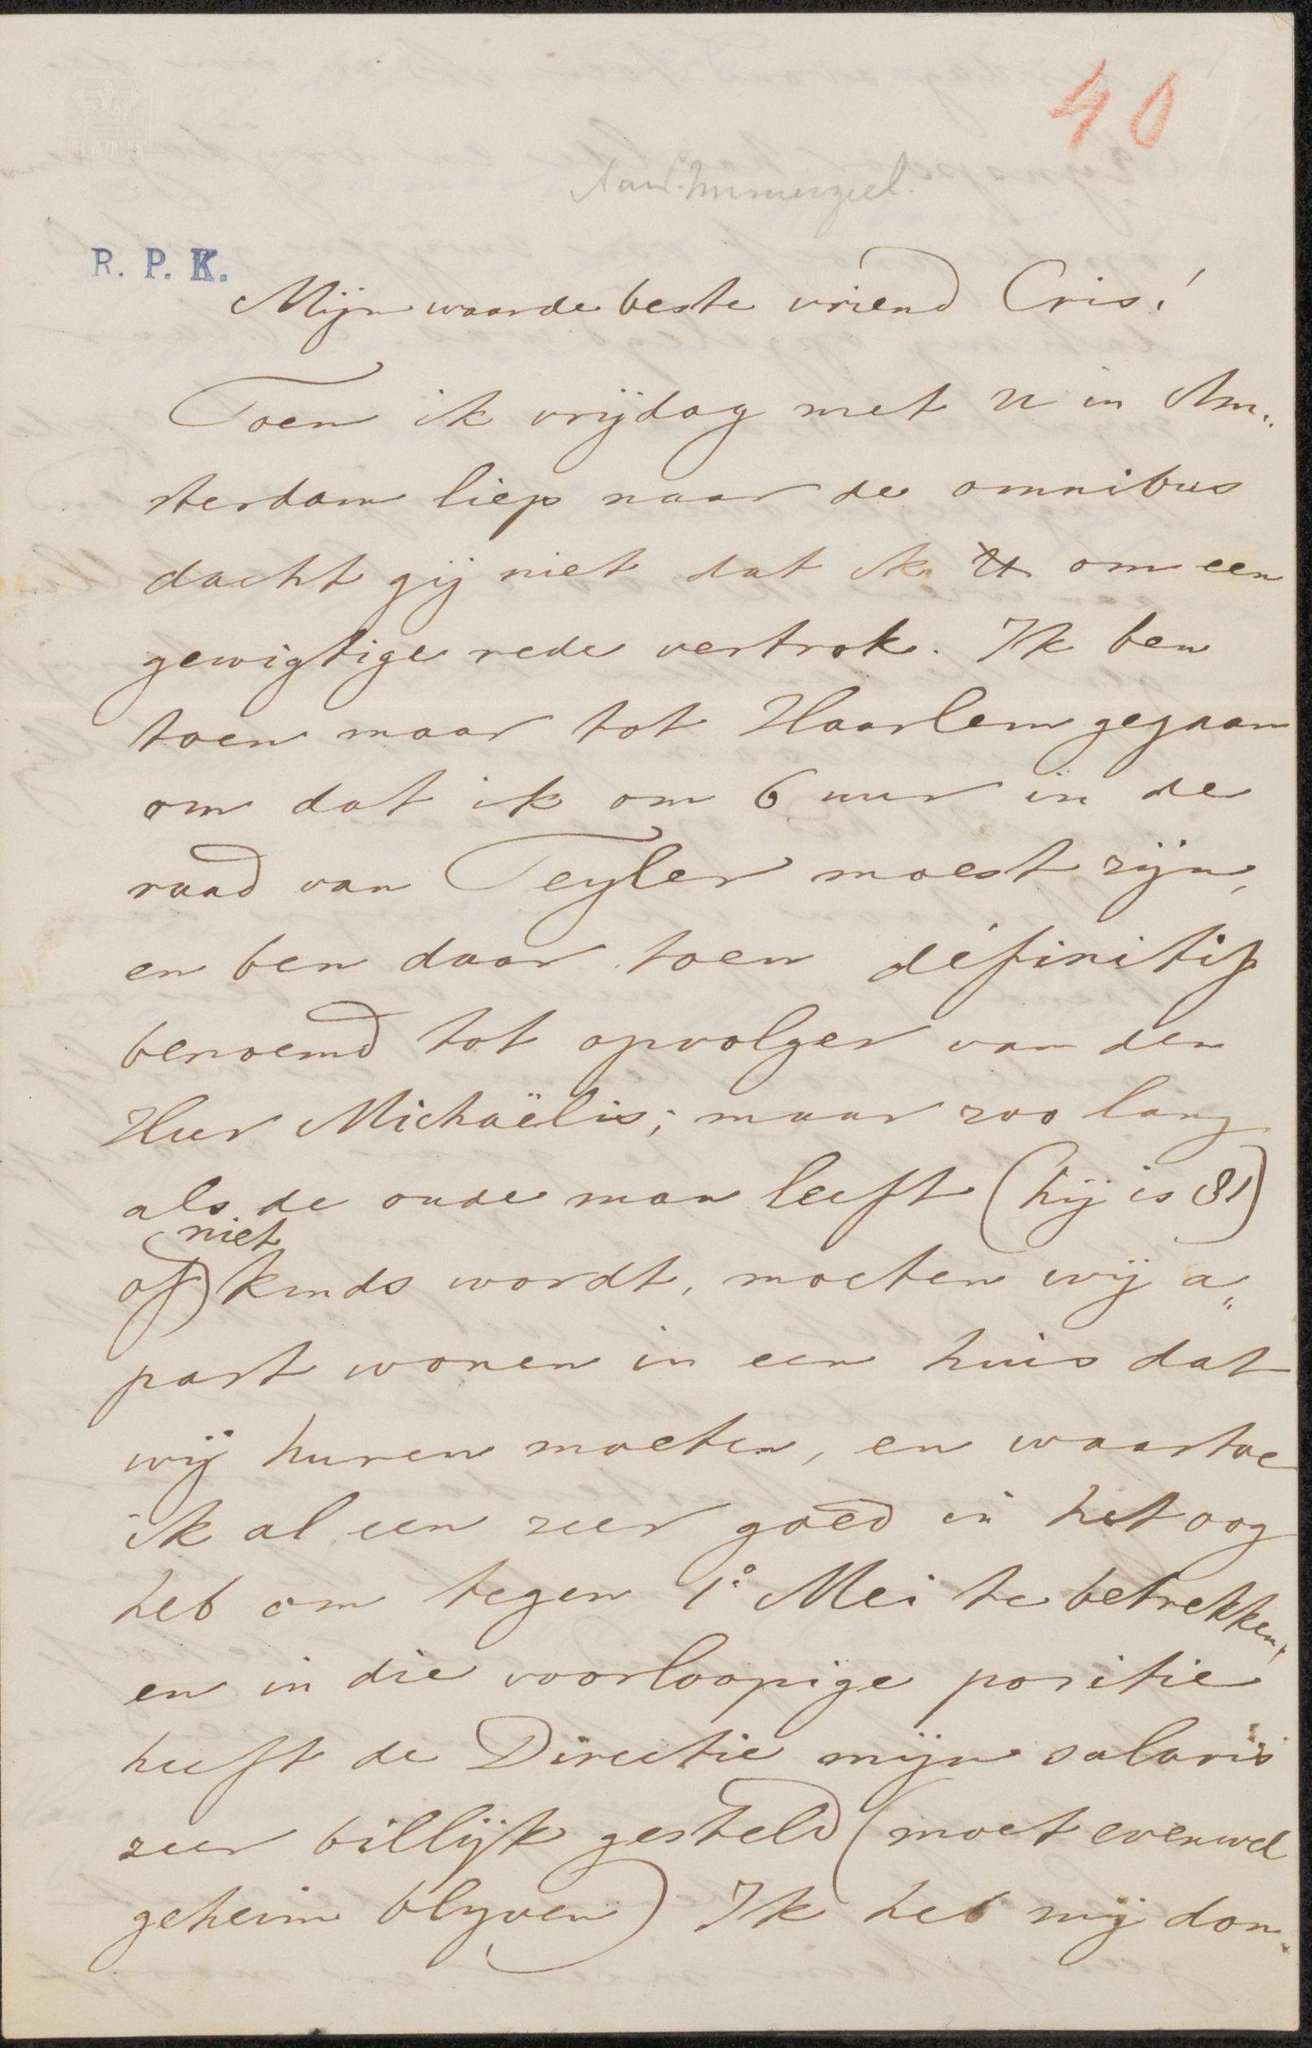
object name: letter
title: Brief aan Christiaan Kramm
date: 1861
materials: ink, paper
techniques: pen, writing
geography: haarlem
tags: painter, jan van scorel, utrecht, print maker, draughtsman, christiaan kramm, adrianus johannes ehnle, drawing, painting (including book-illumination, miniature-painting), historical persons (portraits and scenes from the life)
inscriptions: collector's mark: Lugt 2233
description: Brief bevat verso aantekening van Christiaan Kramm over Adrianus Johannes Ehnle.